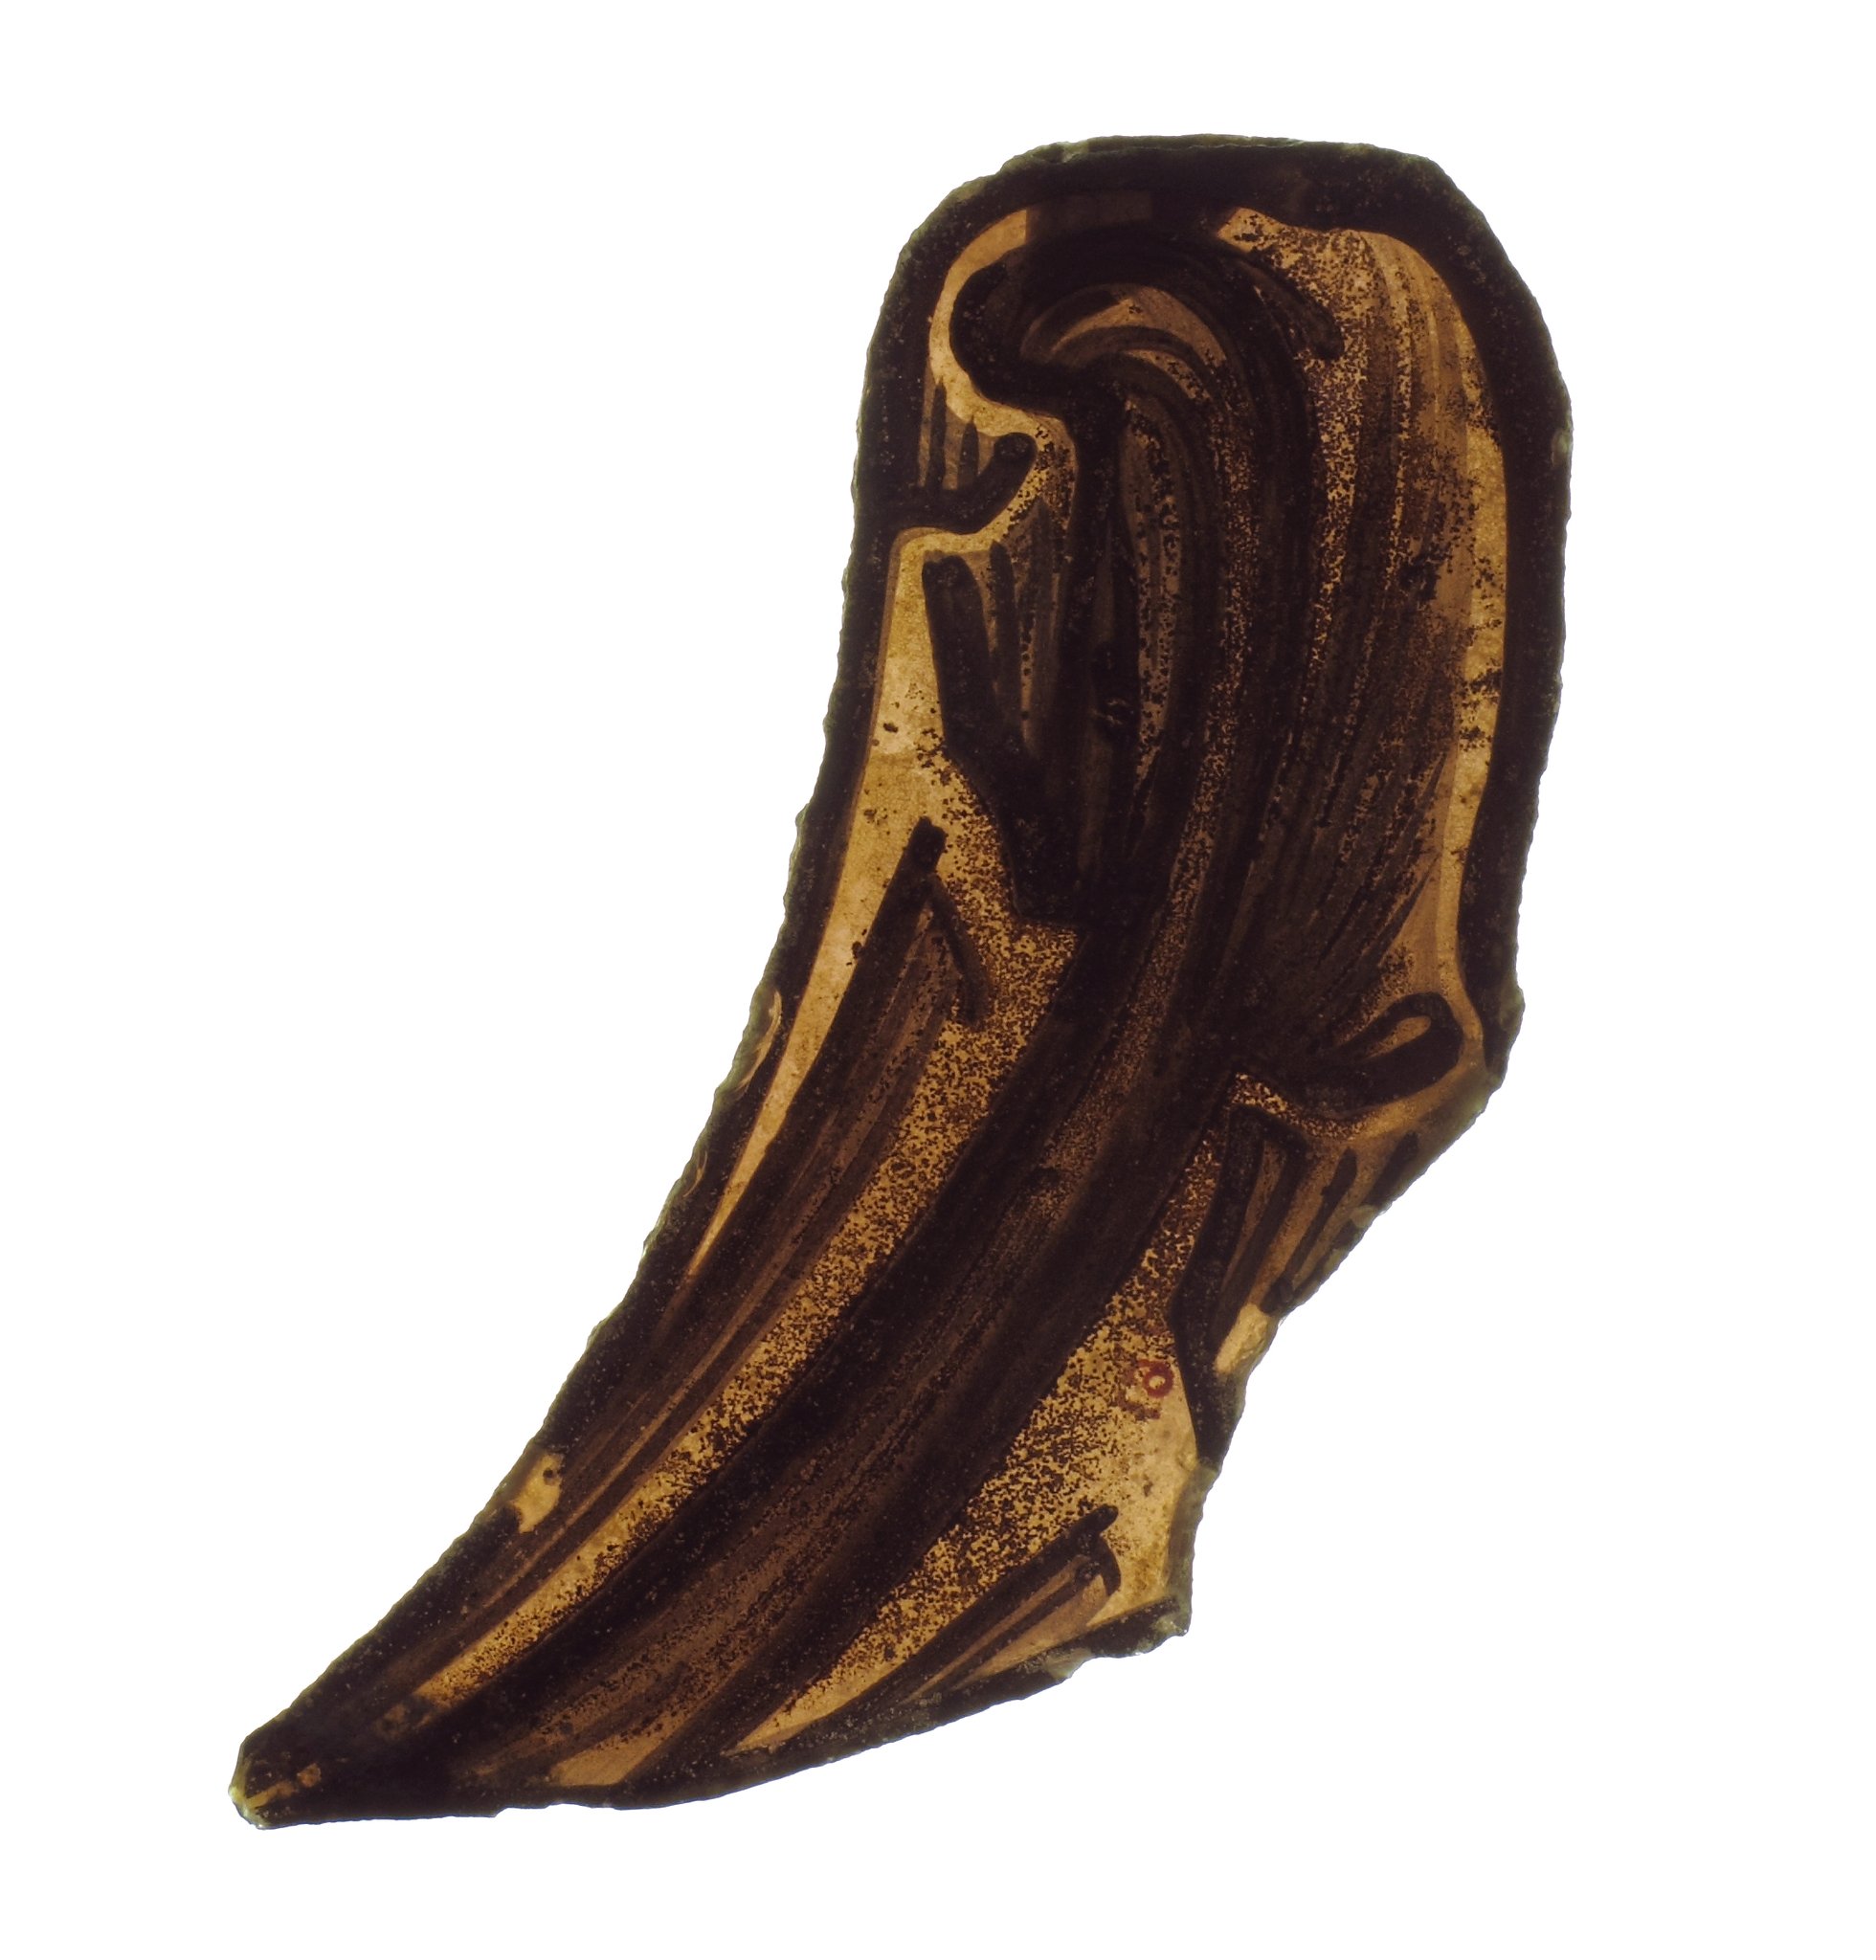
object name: fragment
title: Glass Fragment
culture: french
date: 1101-1400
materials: glass, metal, paint